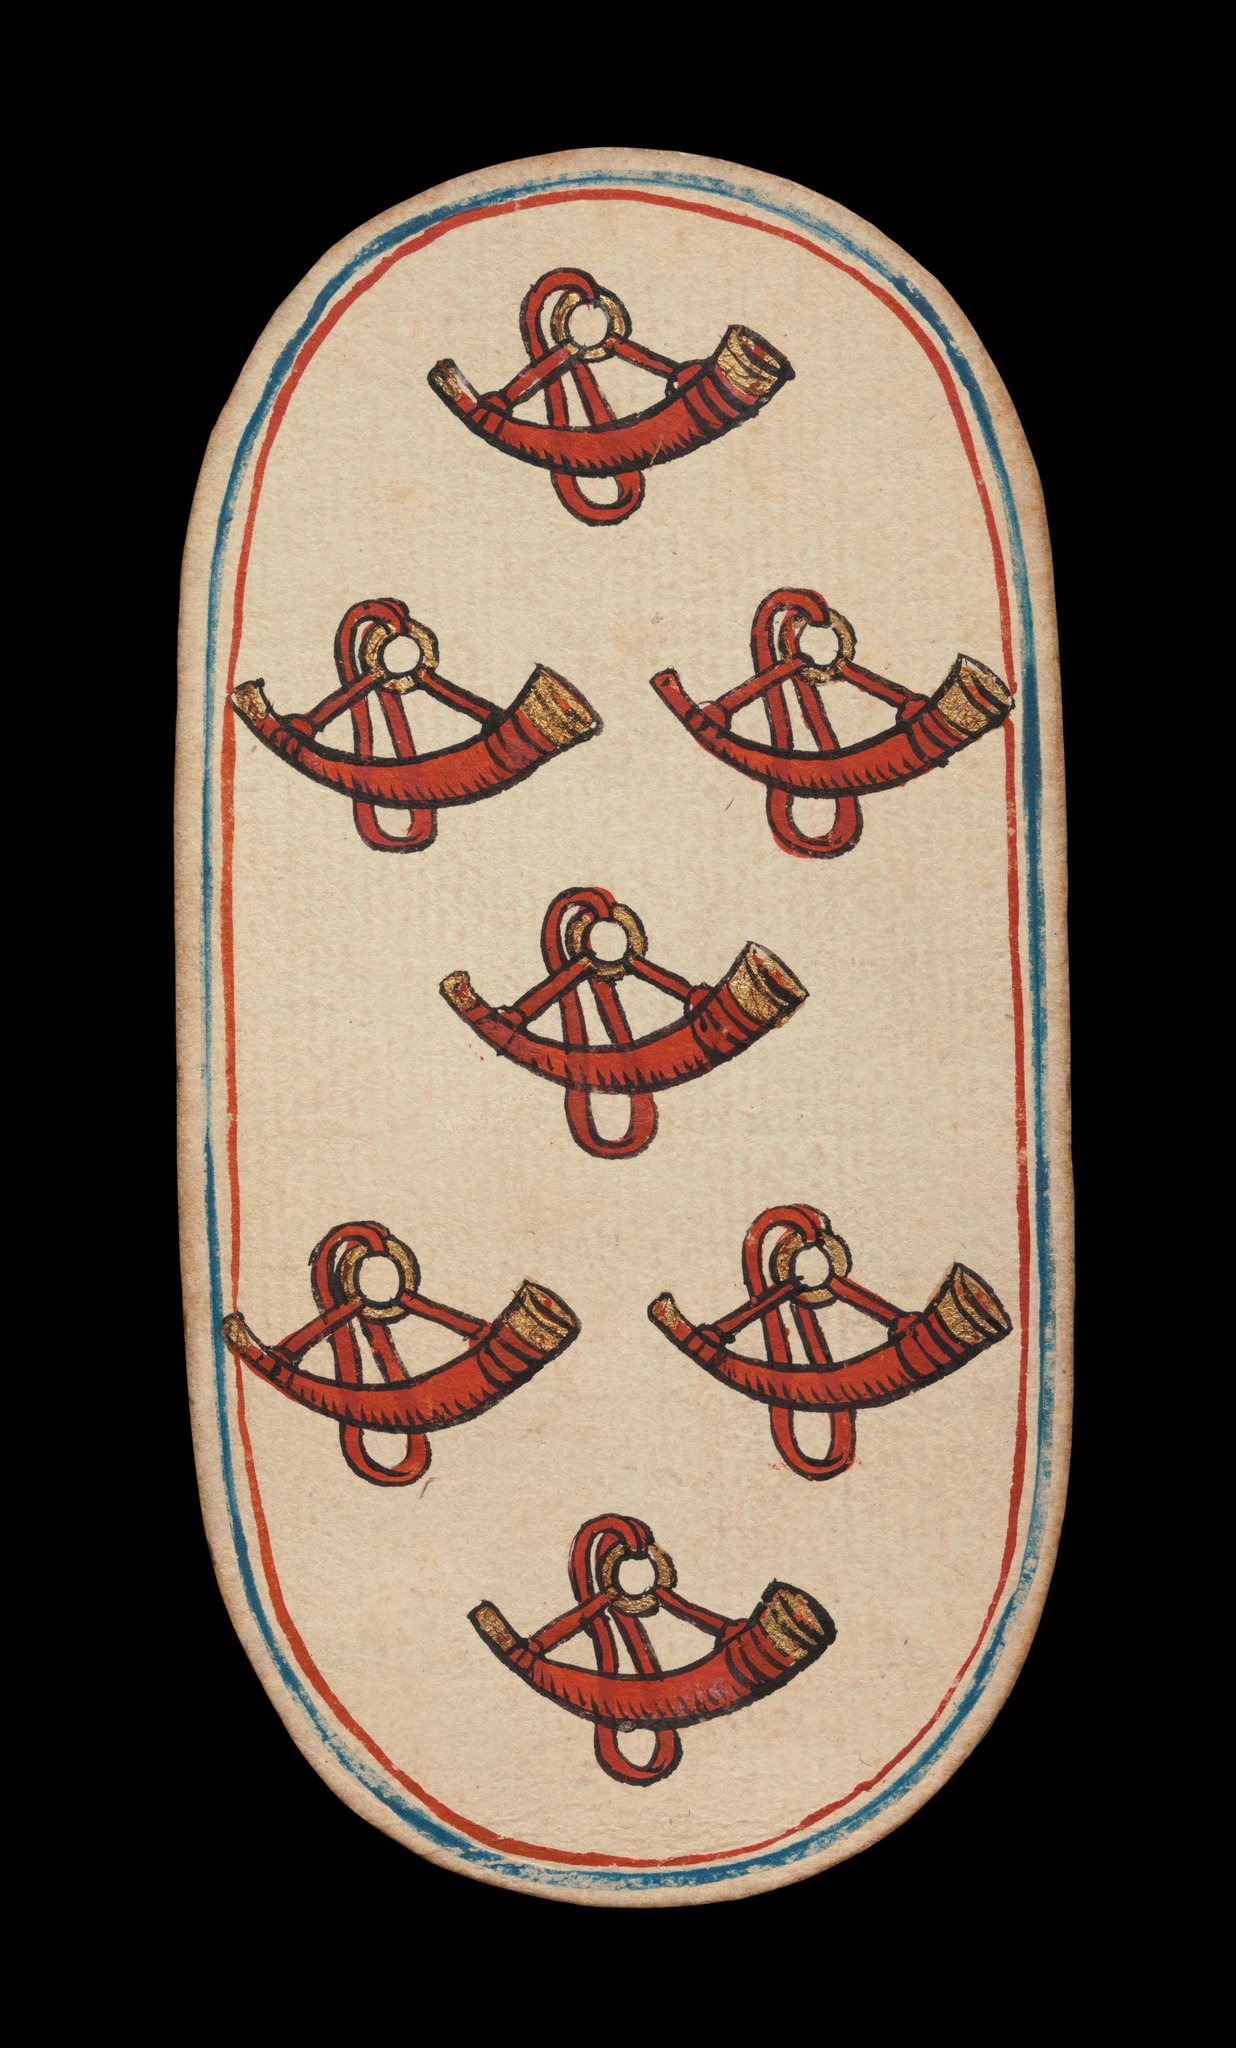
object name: playing card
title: 7 of Horns, from The Cloisters Playing Cards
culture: south netherlandish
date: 1475-1480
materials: glaze, gold, ink, paint, paper, silver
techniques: pen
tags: playing cards,horns,games